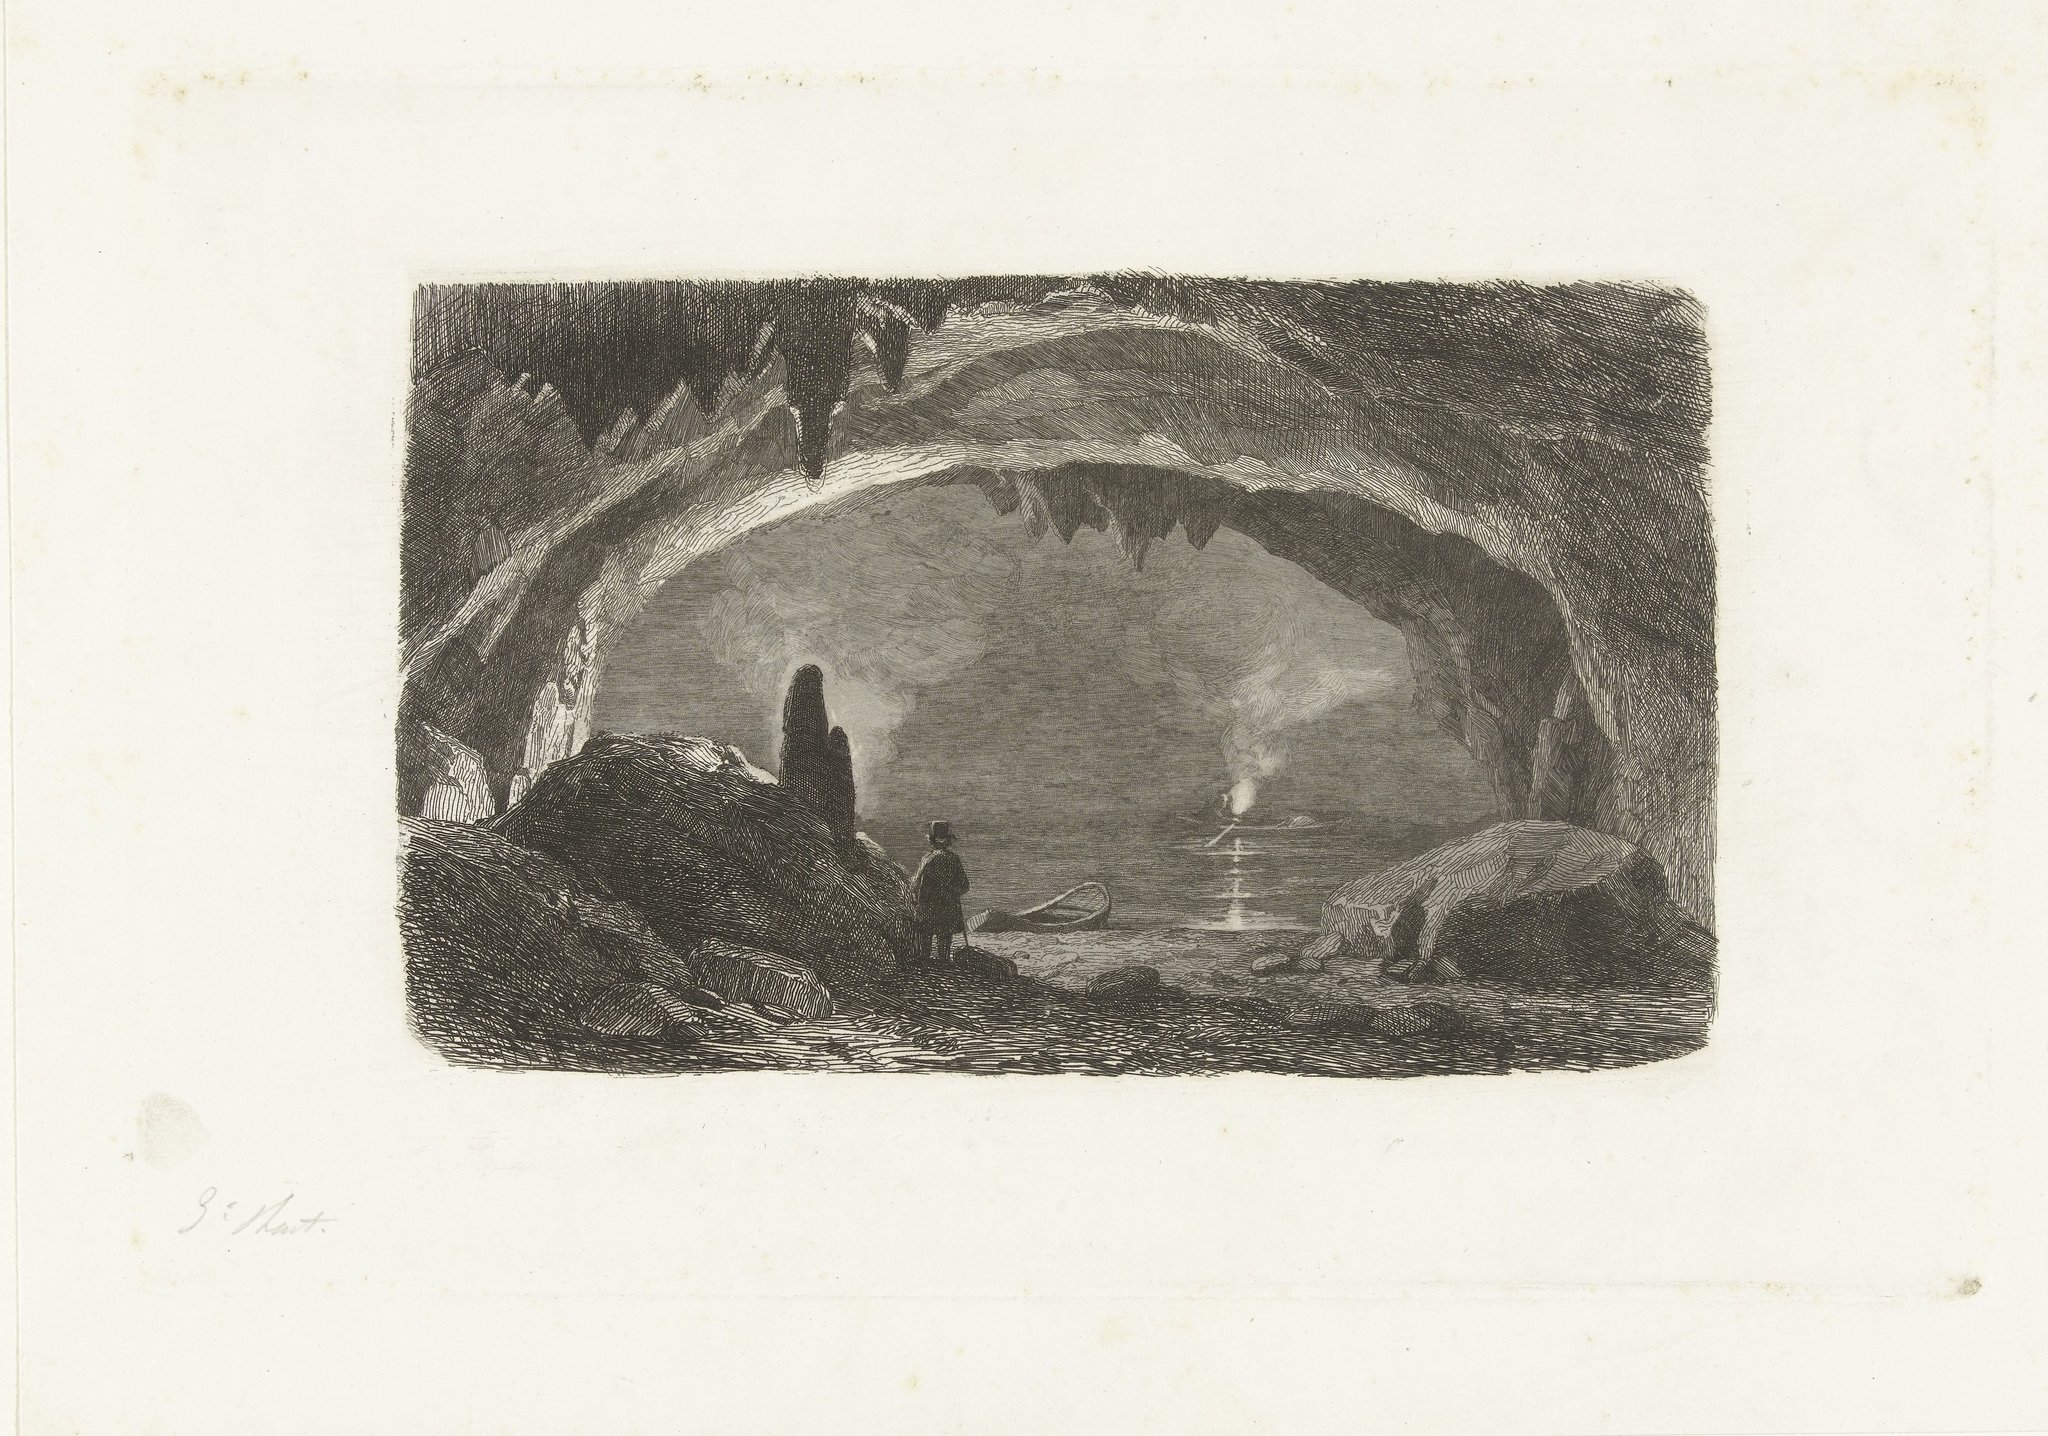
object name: print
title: Man met roeiboot in de grotten van Han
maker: pierre louis dubourcq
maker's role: draughtsman, painter, print maker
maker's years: 1815-1873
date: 1849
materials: paper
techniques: steel etching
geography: netherlands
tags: cave, grotto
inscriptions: collector's mark: Lugt 2228